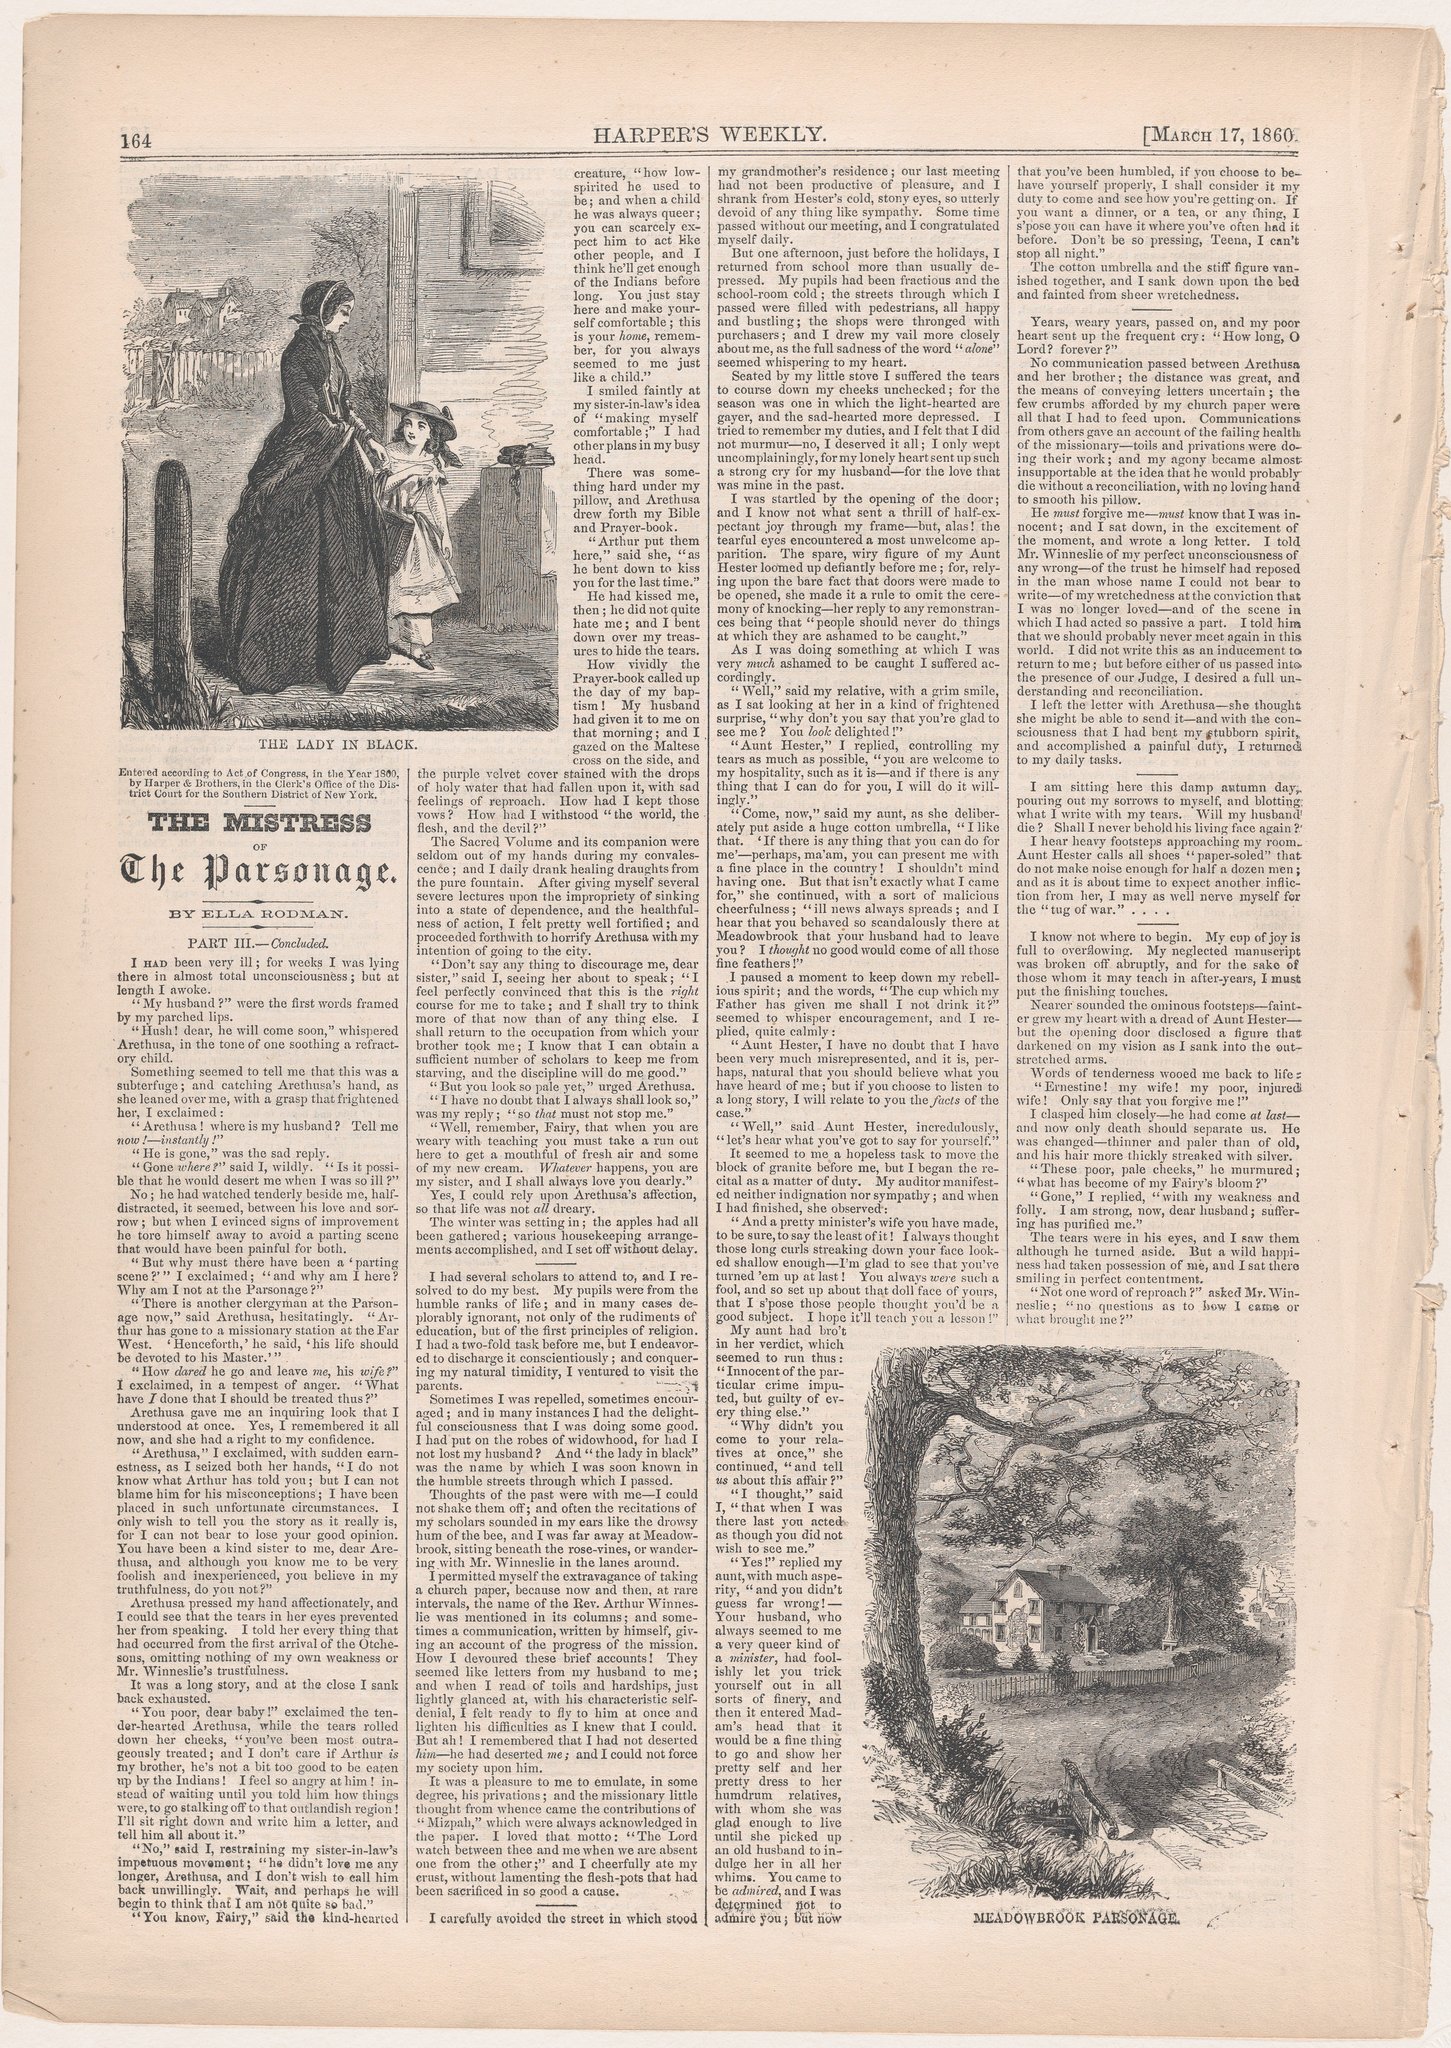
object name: print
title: The Lady in Black, Meadowbrook Parsonage (from "The Mistress of the Parsonage," in "Harper's Weekly")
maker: winslow homer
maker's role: artist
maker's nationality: american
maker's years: 1836-1910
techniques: engraving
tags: girls,women,landscapes